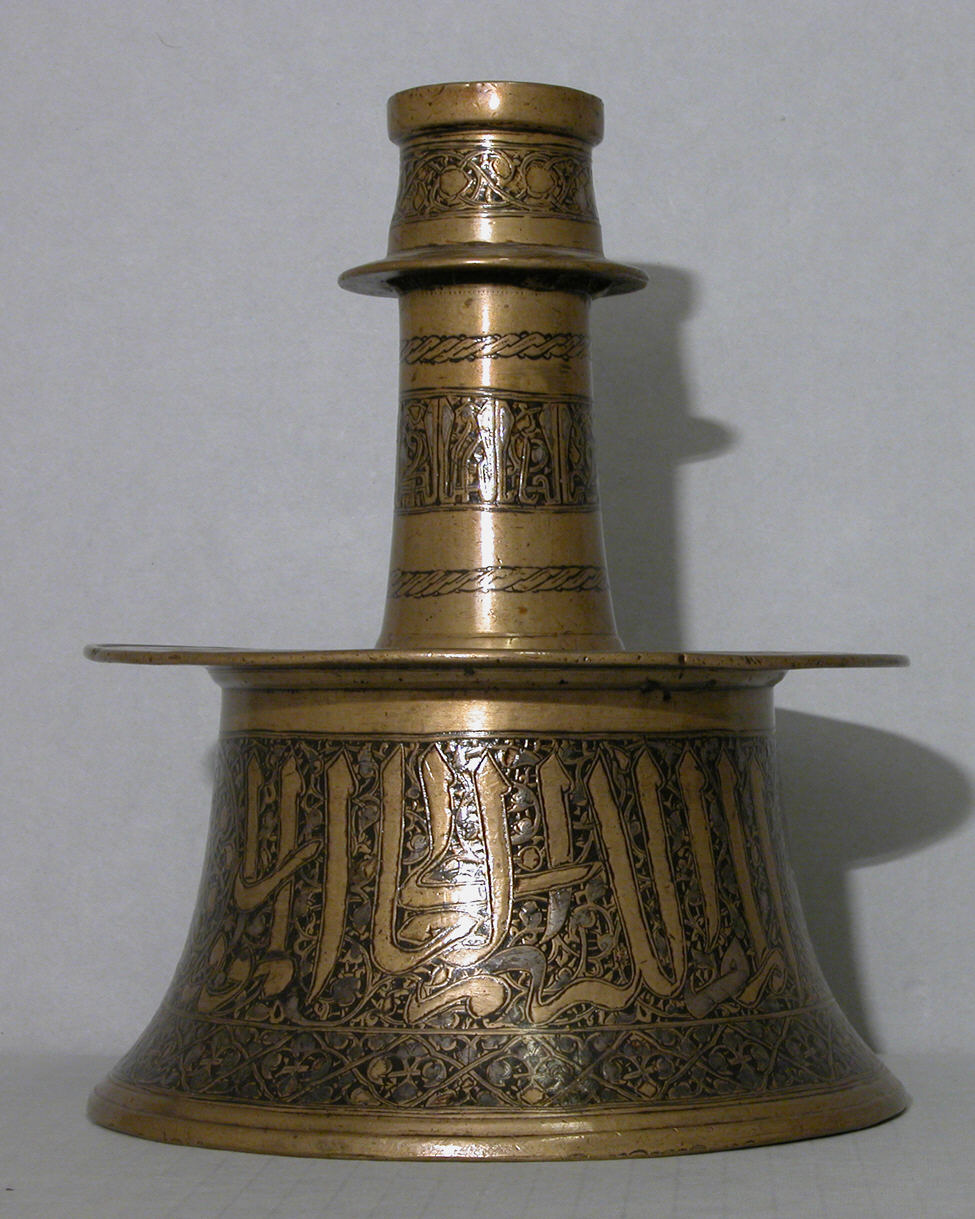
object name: candlestick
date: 1301-1350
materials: brass, silver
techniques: inlay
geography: egypt or syria